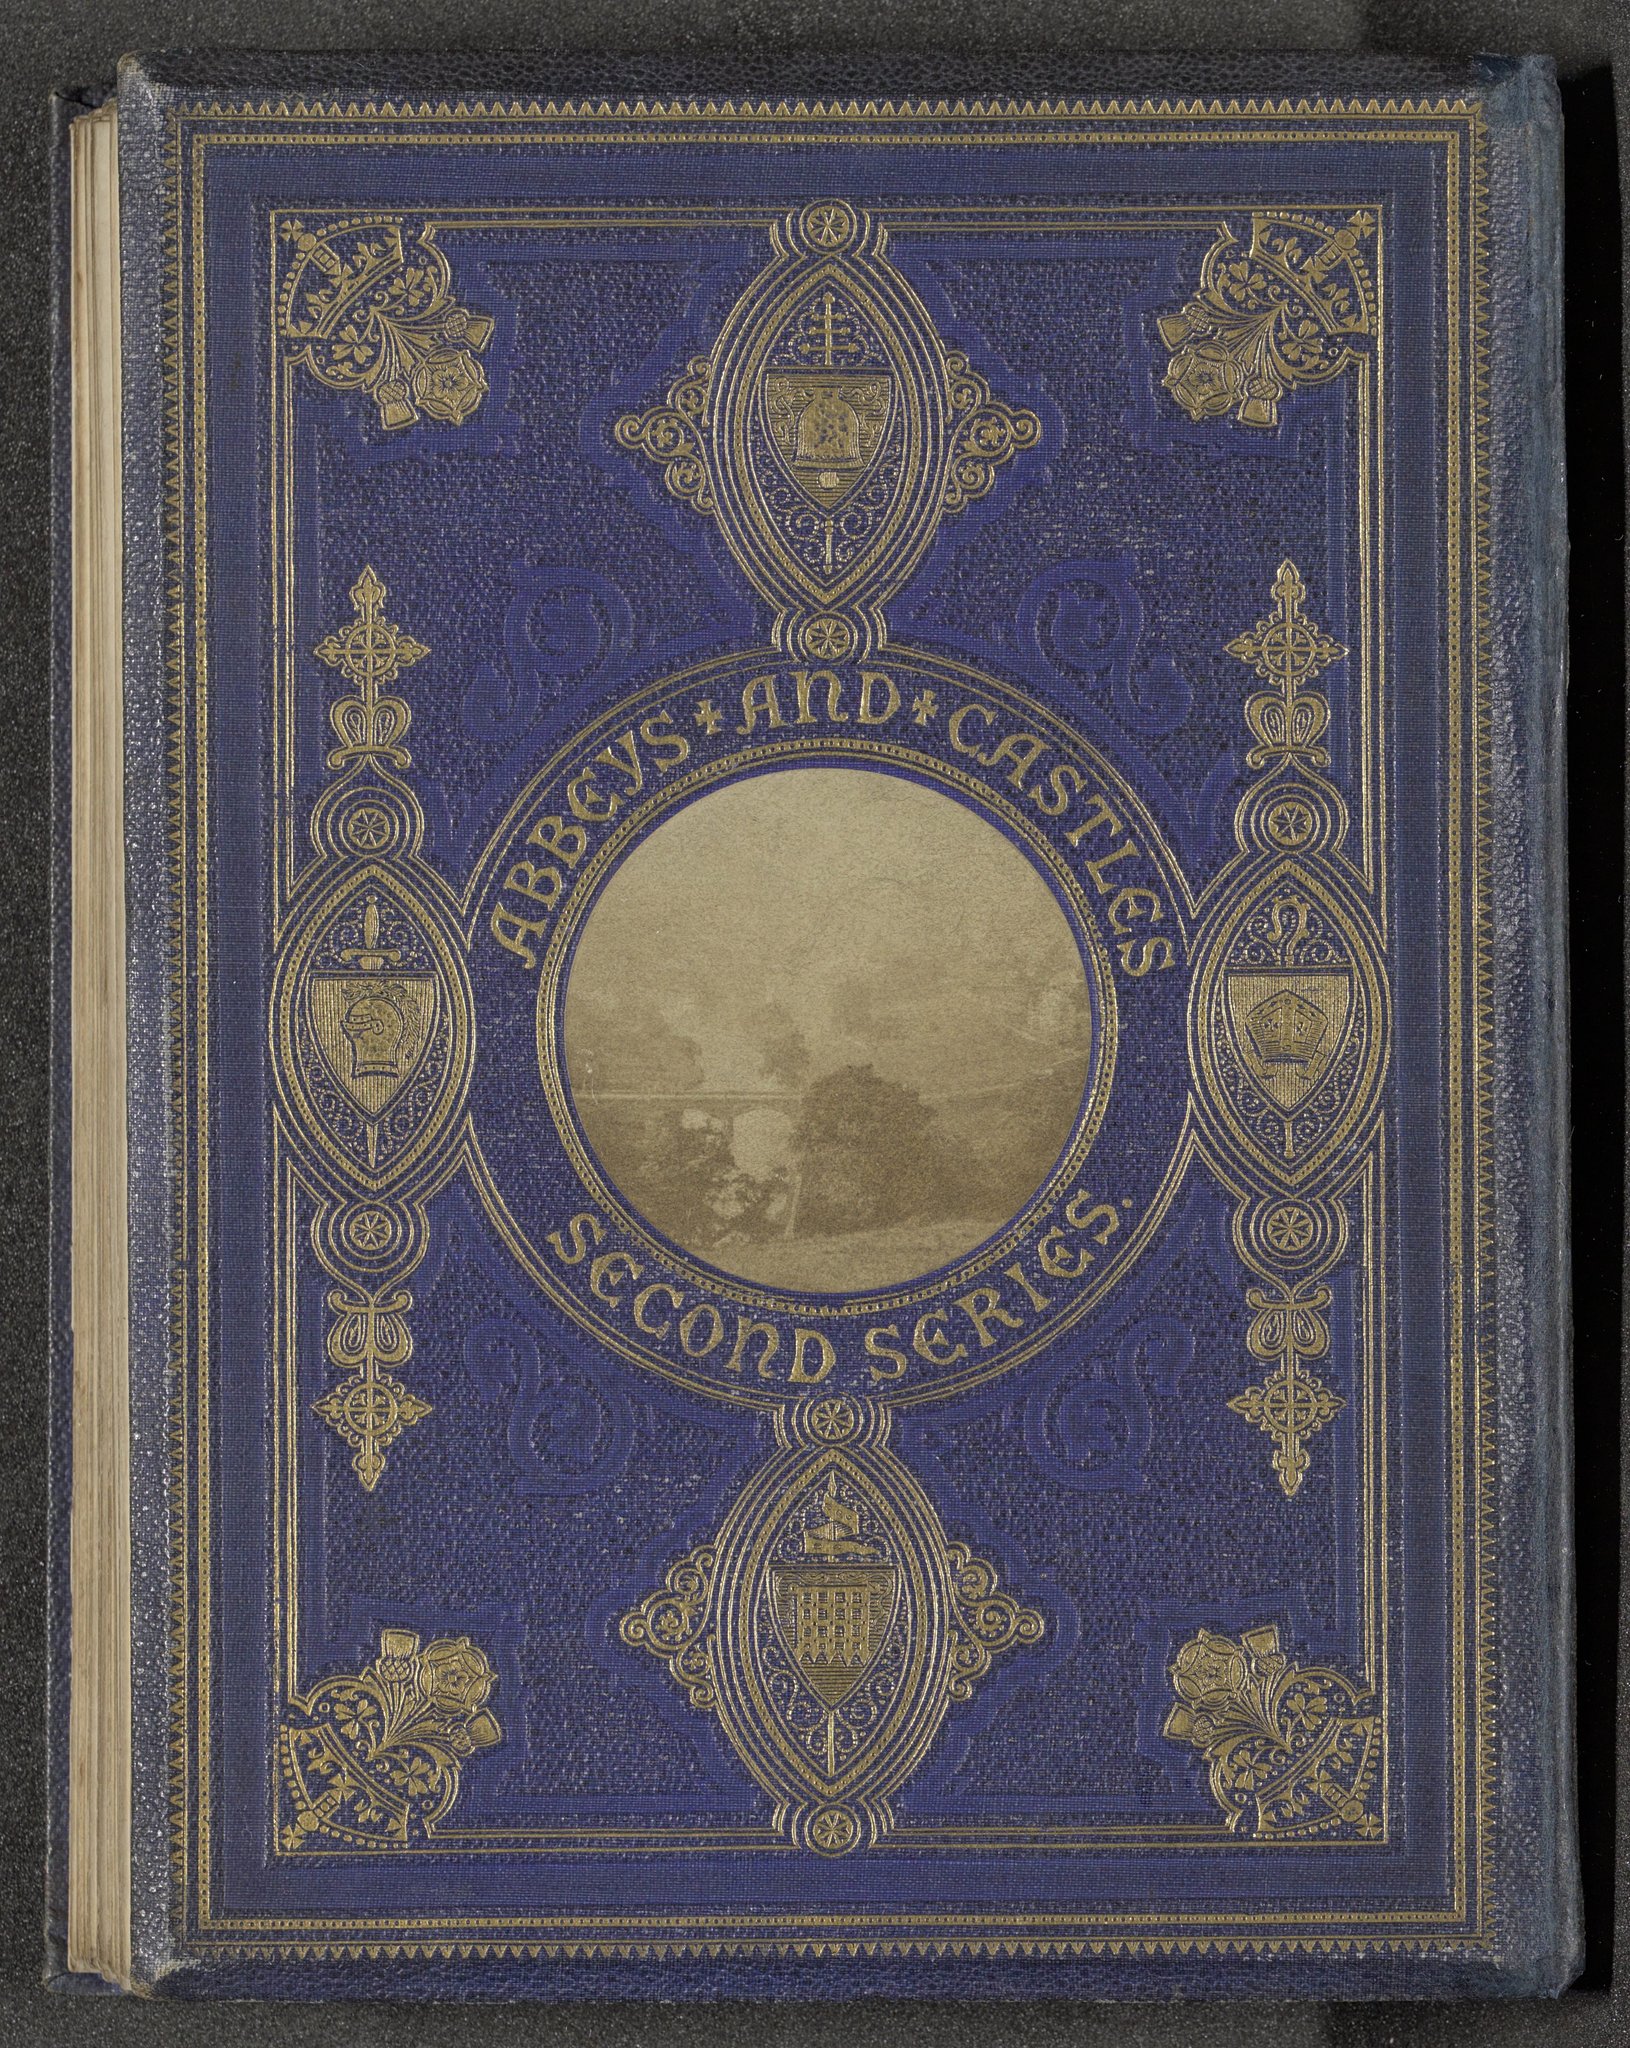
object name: photograph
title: Landschap met een brug over een rivier en een ruïne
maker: Anonymous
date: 1854-1864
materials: photographic support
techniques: albumen print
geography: united kingdom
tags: landscape with bridge, viaduct or aqueduct